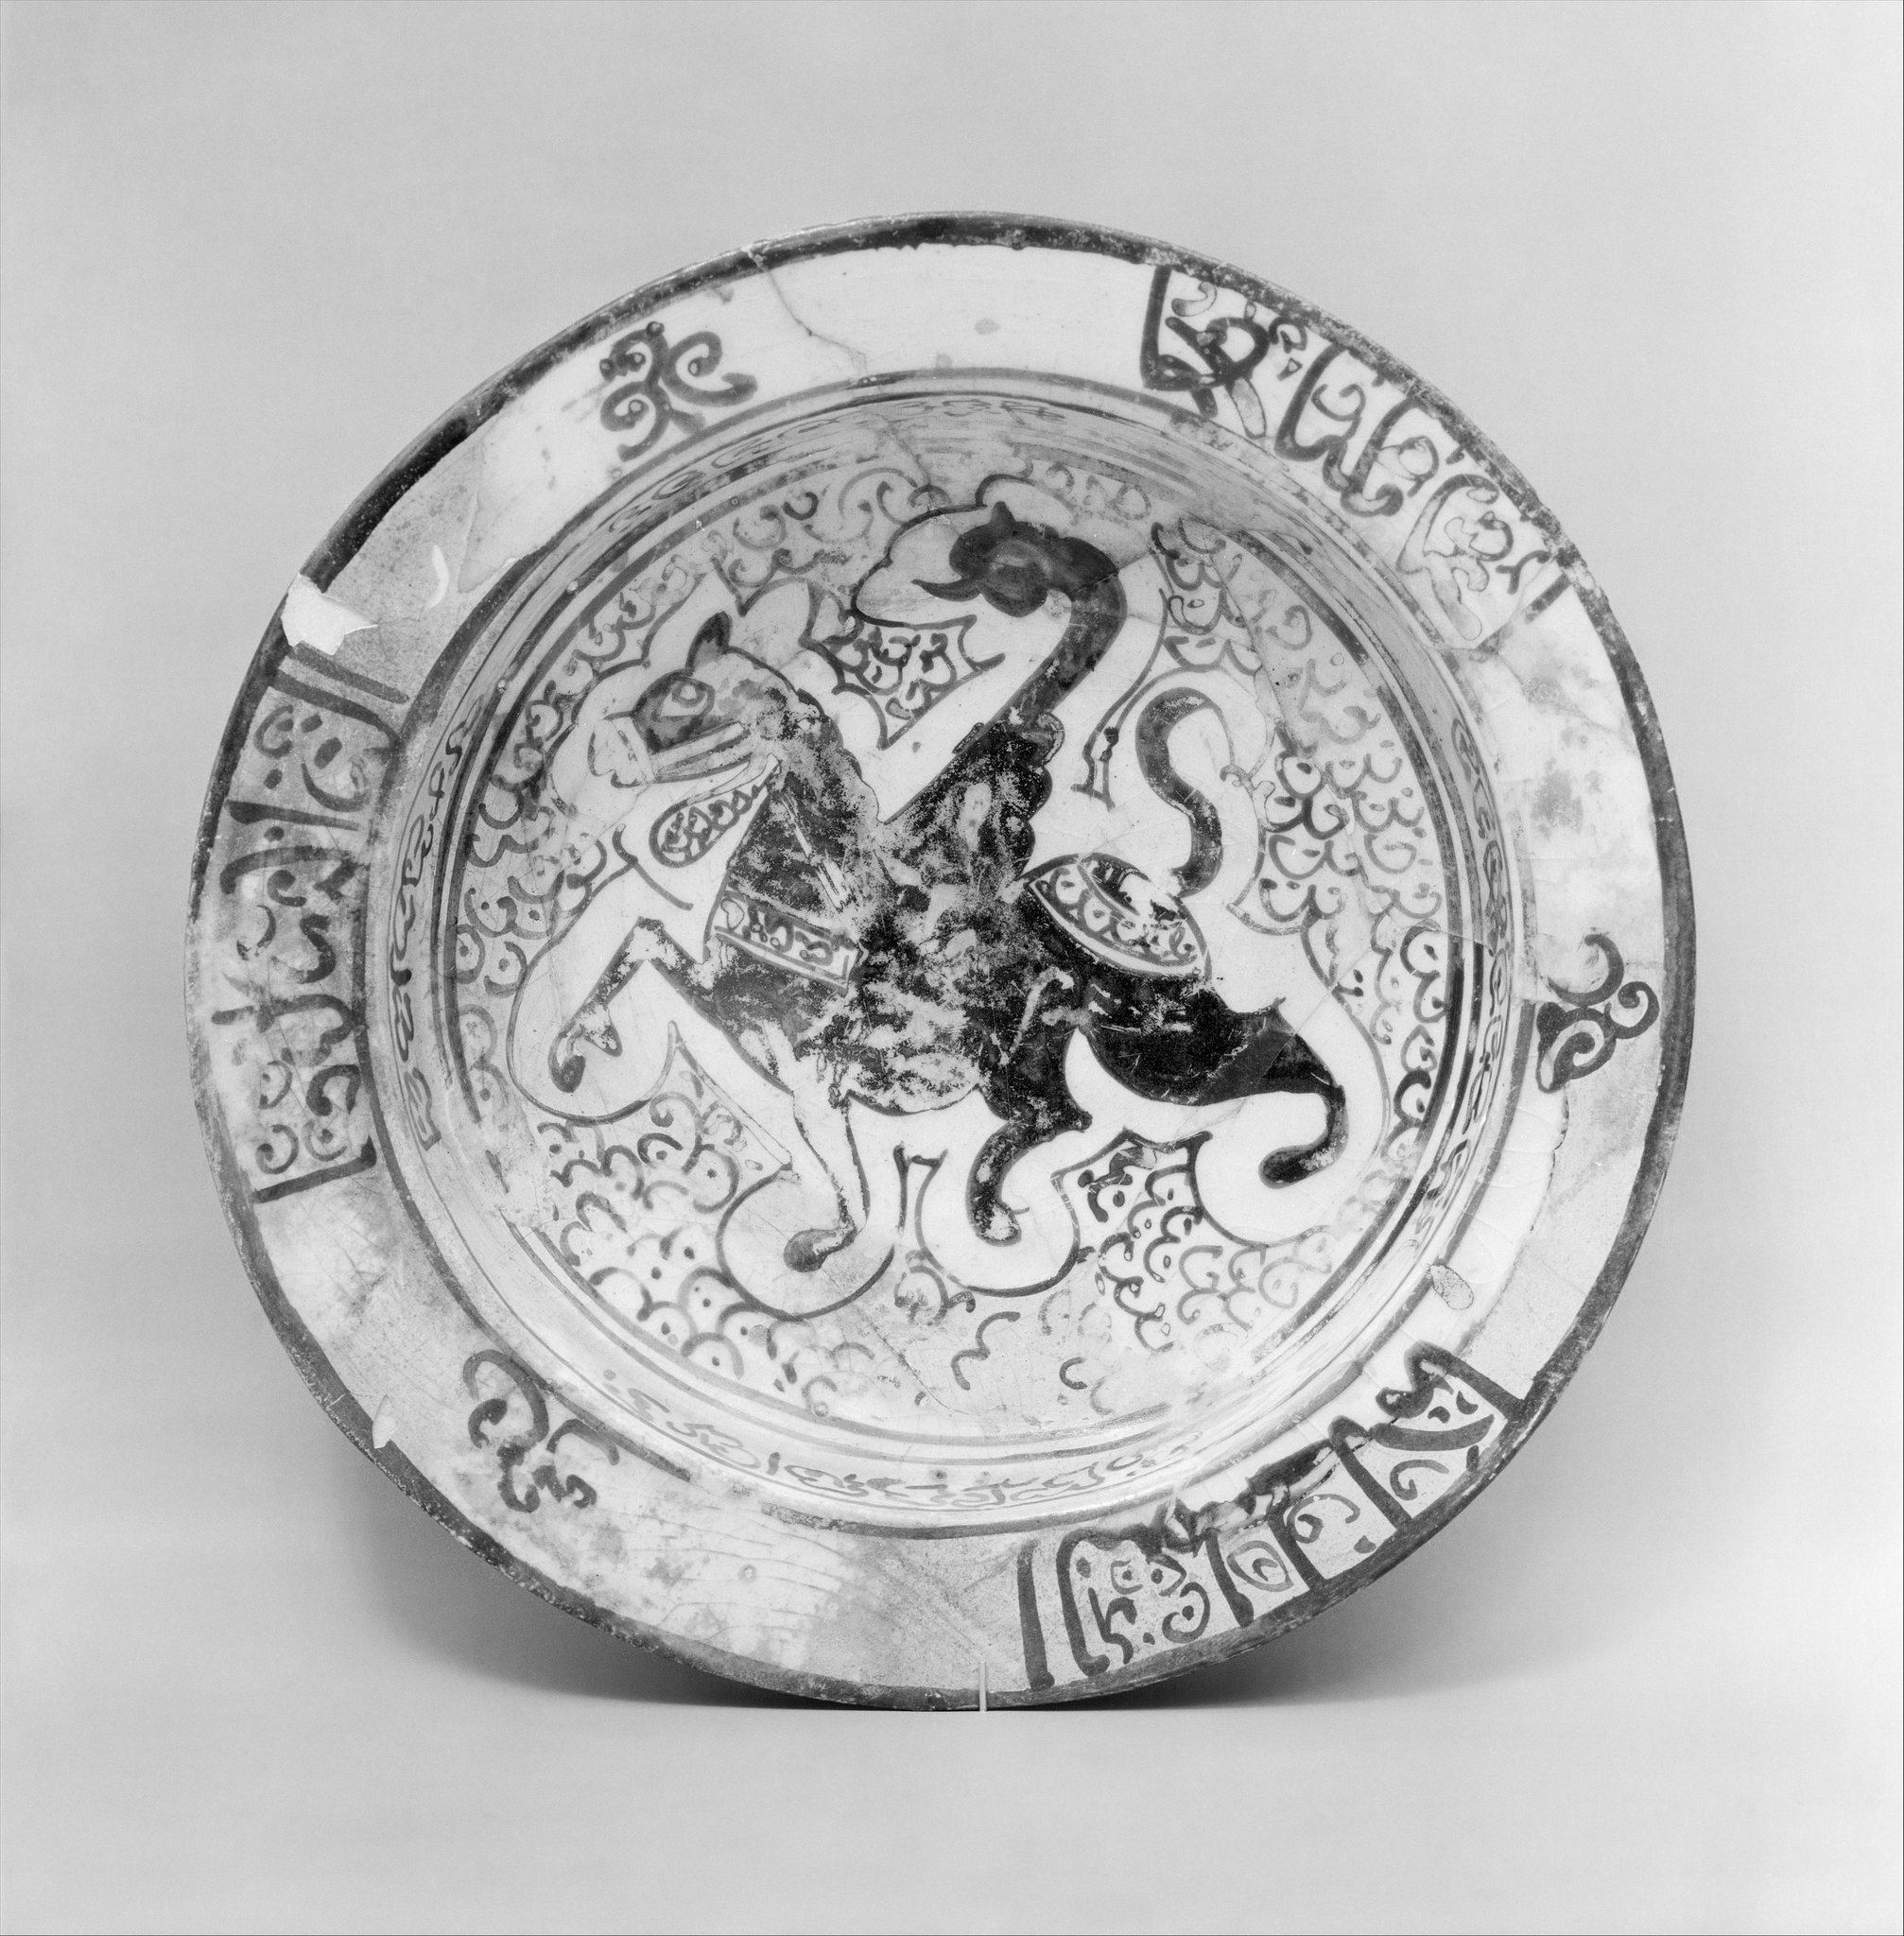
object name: bowl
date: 1134-1166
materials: stonepaste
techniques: luster painting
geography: syria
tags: horses